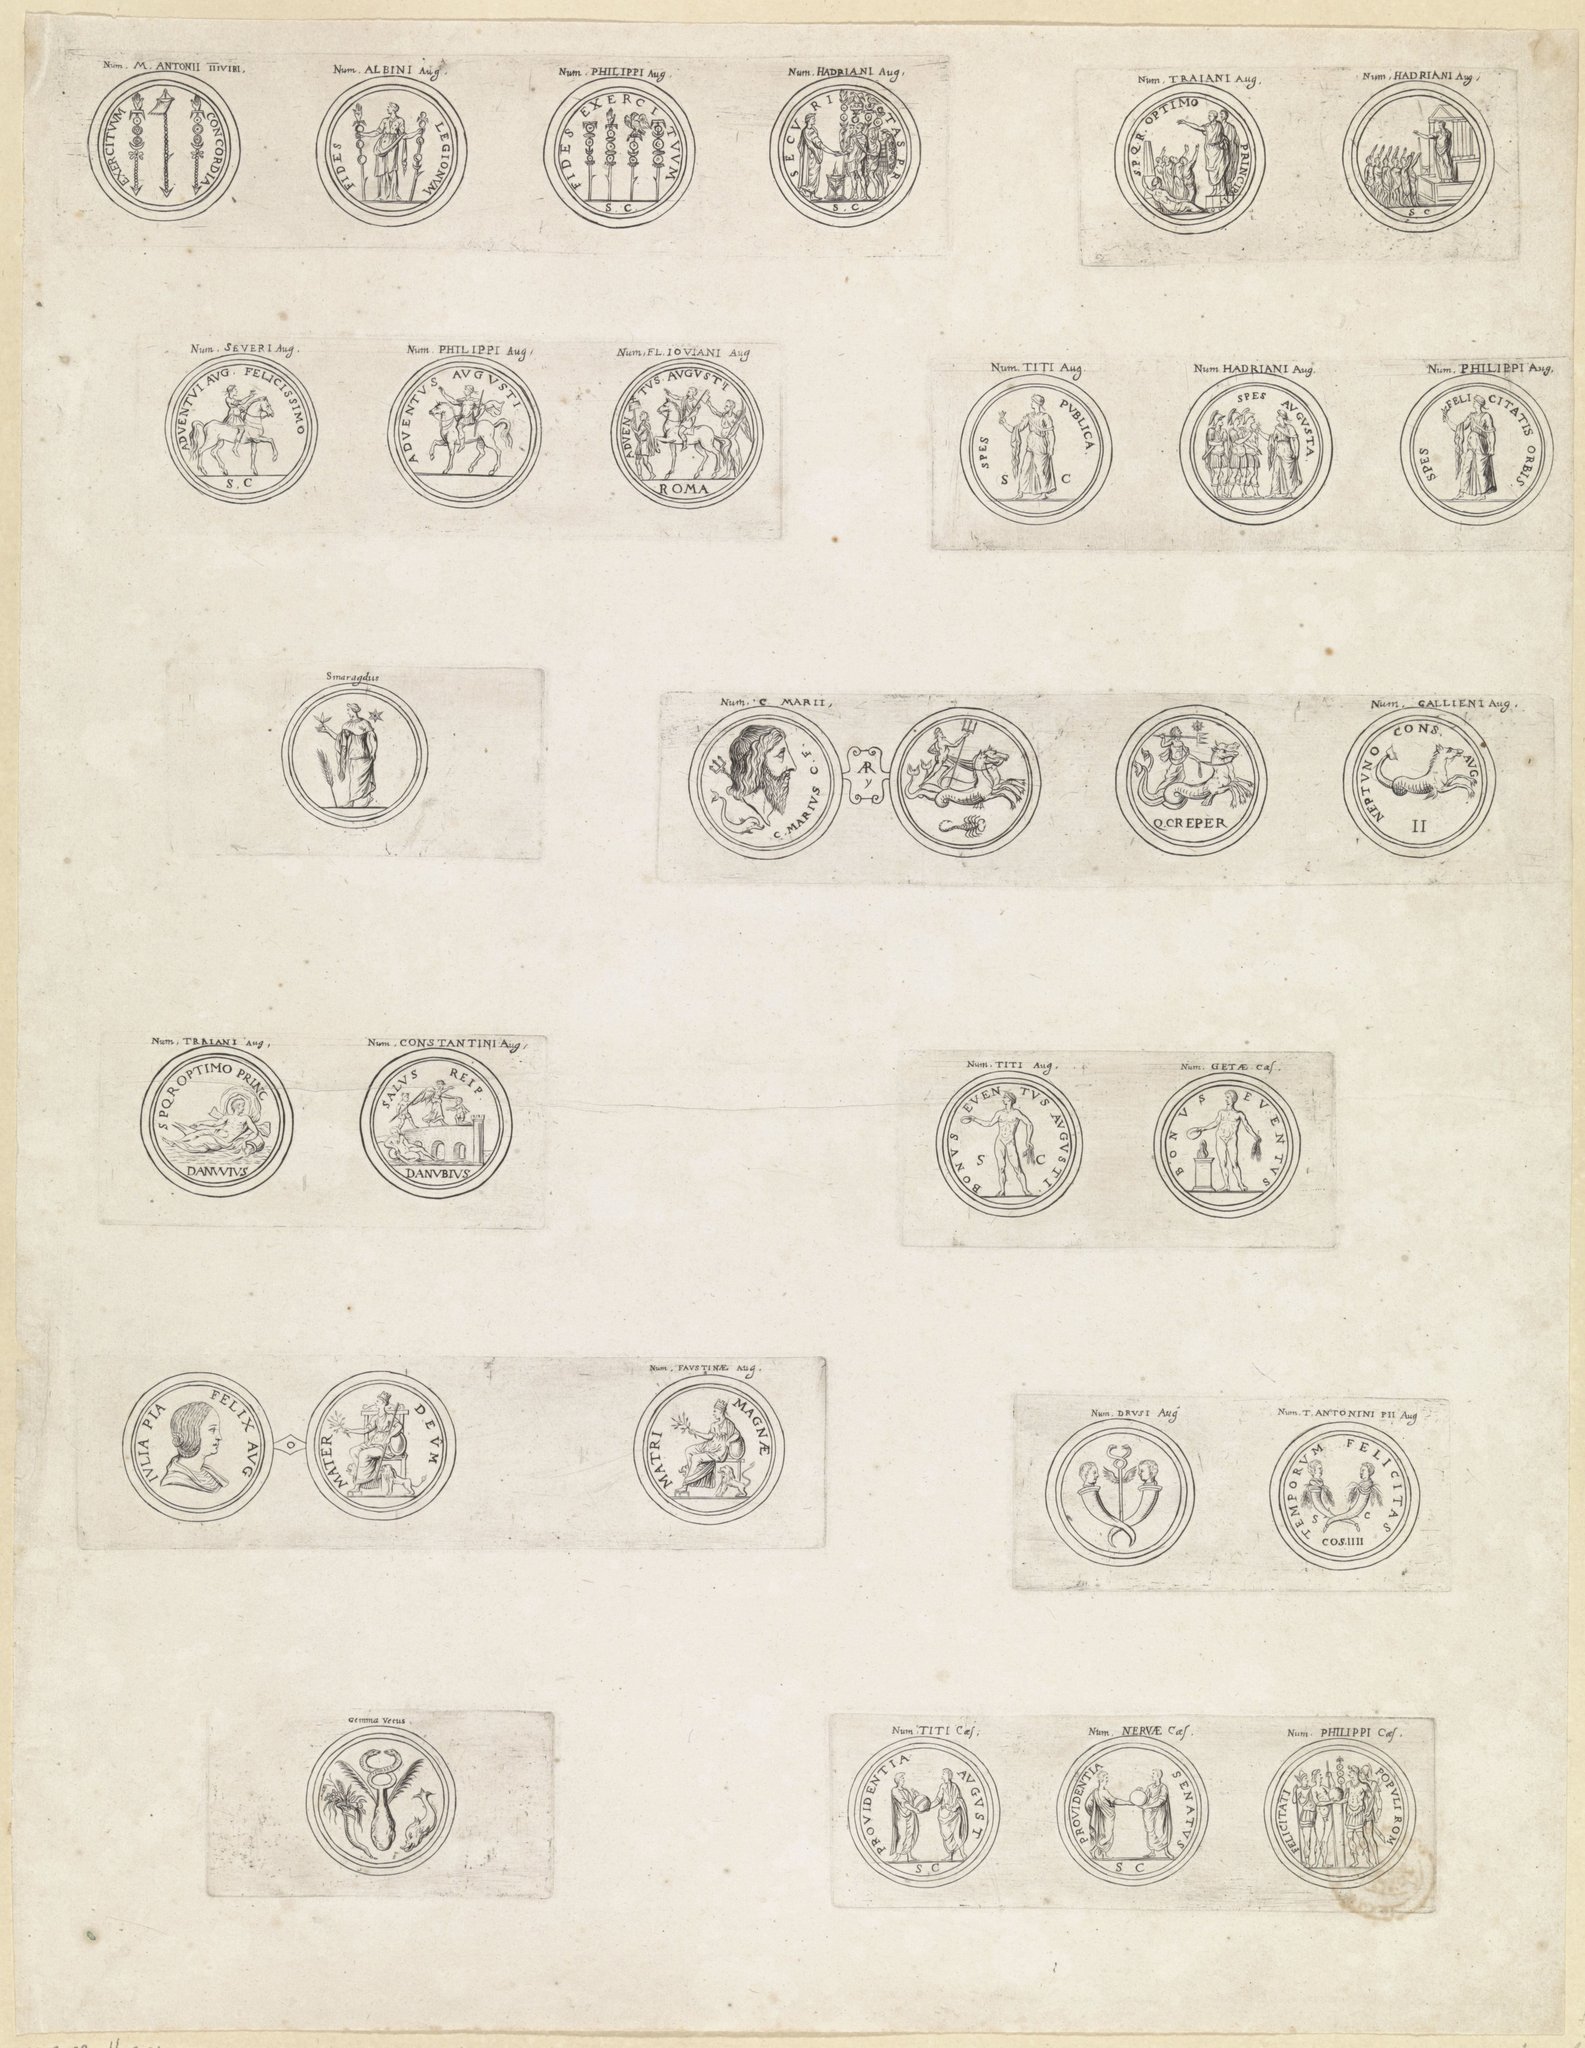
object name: print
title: Dertig Romeinse munten met deviezen en emblemen van keizers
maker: theodoor van thulden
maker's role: draughtsman, painter, print maker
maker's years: 1606-1669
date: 1642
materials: paper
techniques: engraving, etching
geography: antwerp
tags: coin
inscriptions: collector's mark: Lugt 240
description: Prenten gebruikt in: Gevartius, Casper. Pompa introitvs (...) Ferdinandi Avstriaci (...) a S. P. Q. Antverp. decreta et adornata; (...) cùm (...) Antverpiam auspicatissimo aduentu suo bearet, XV. kal. maii, ann. M.DC.XXXV. Antwerpen: Jan van Meurs, 1642.